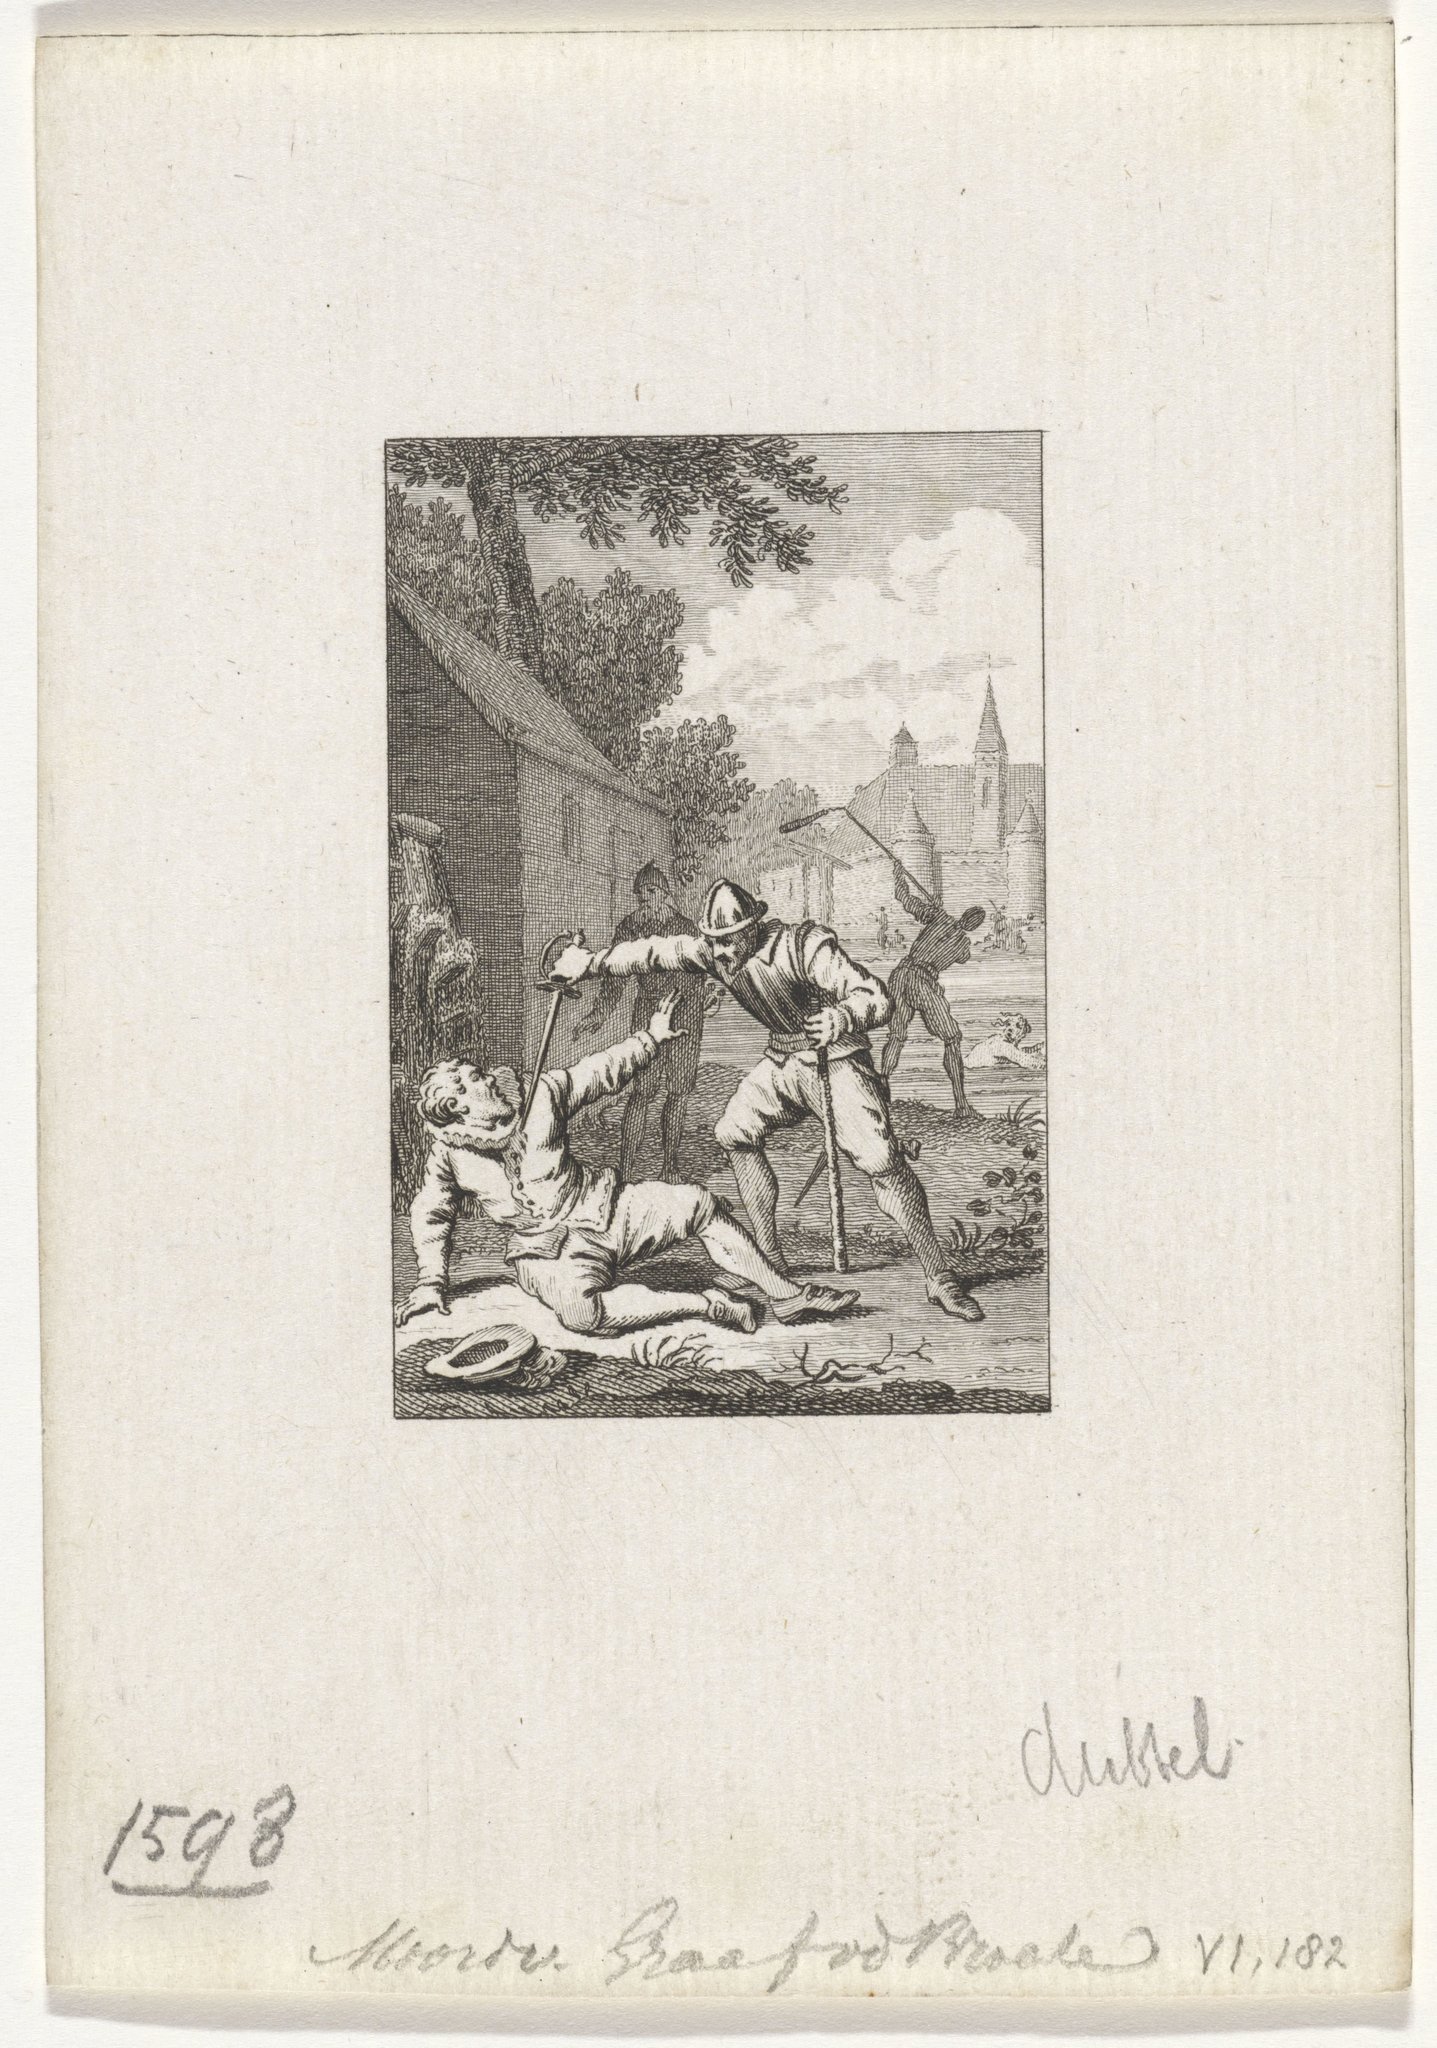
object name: print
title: Moord op Wirich von Daun, graaf van Falkenstein, 1598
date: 1783-1795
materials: paper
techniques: etching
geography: amsterdam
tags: violent death, being killed; being mishandled and maltreated; seeking death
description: Illustratie voor: J. Fokke. Geschiedenissen der Vereenigde Nederlanden voor de vaderlandsche jeugd. Amsterdam: Johannes Allart, 1783-1795, 25 delen, dl. VI, pl. I.